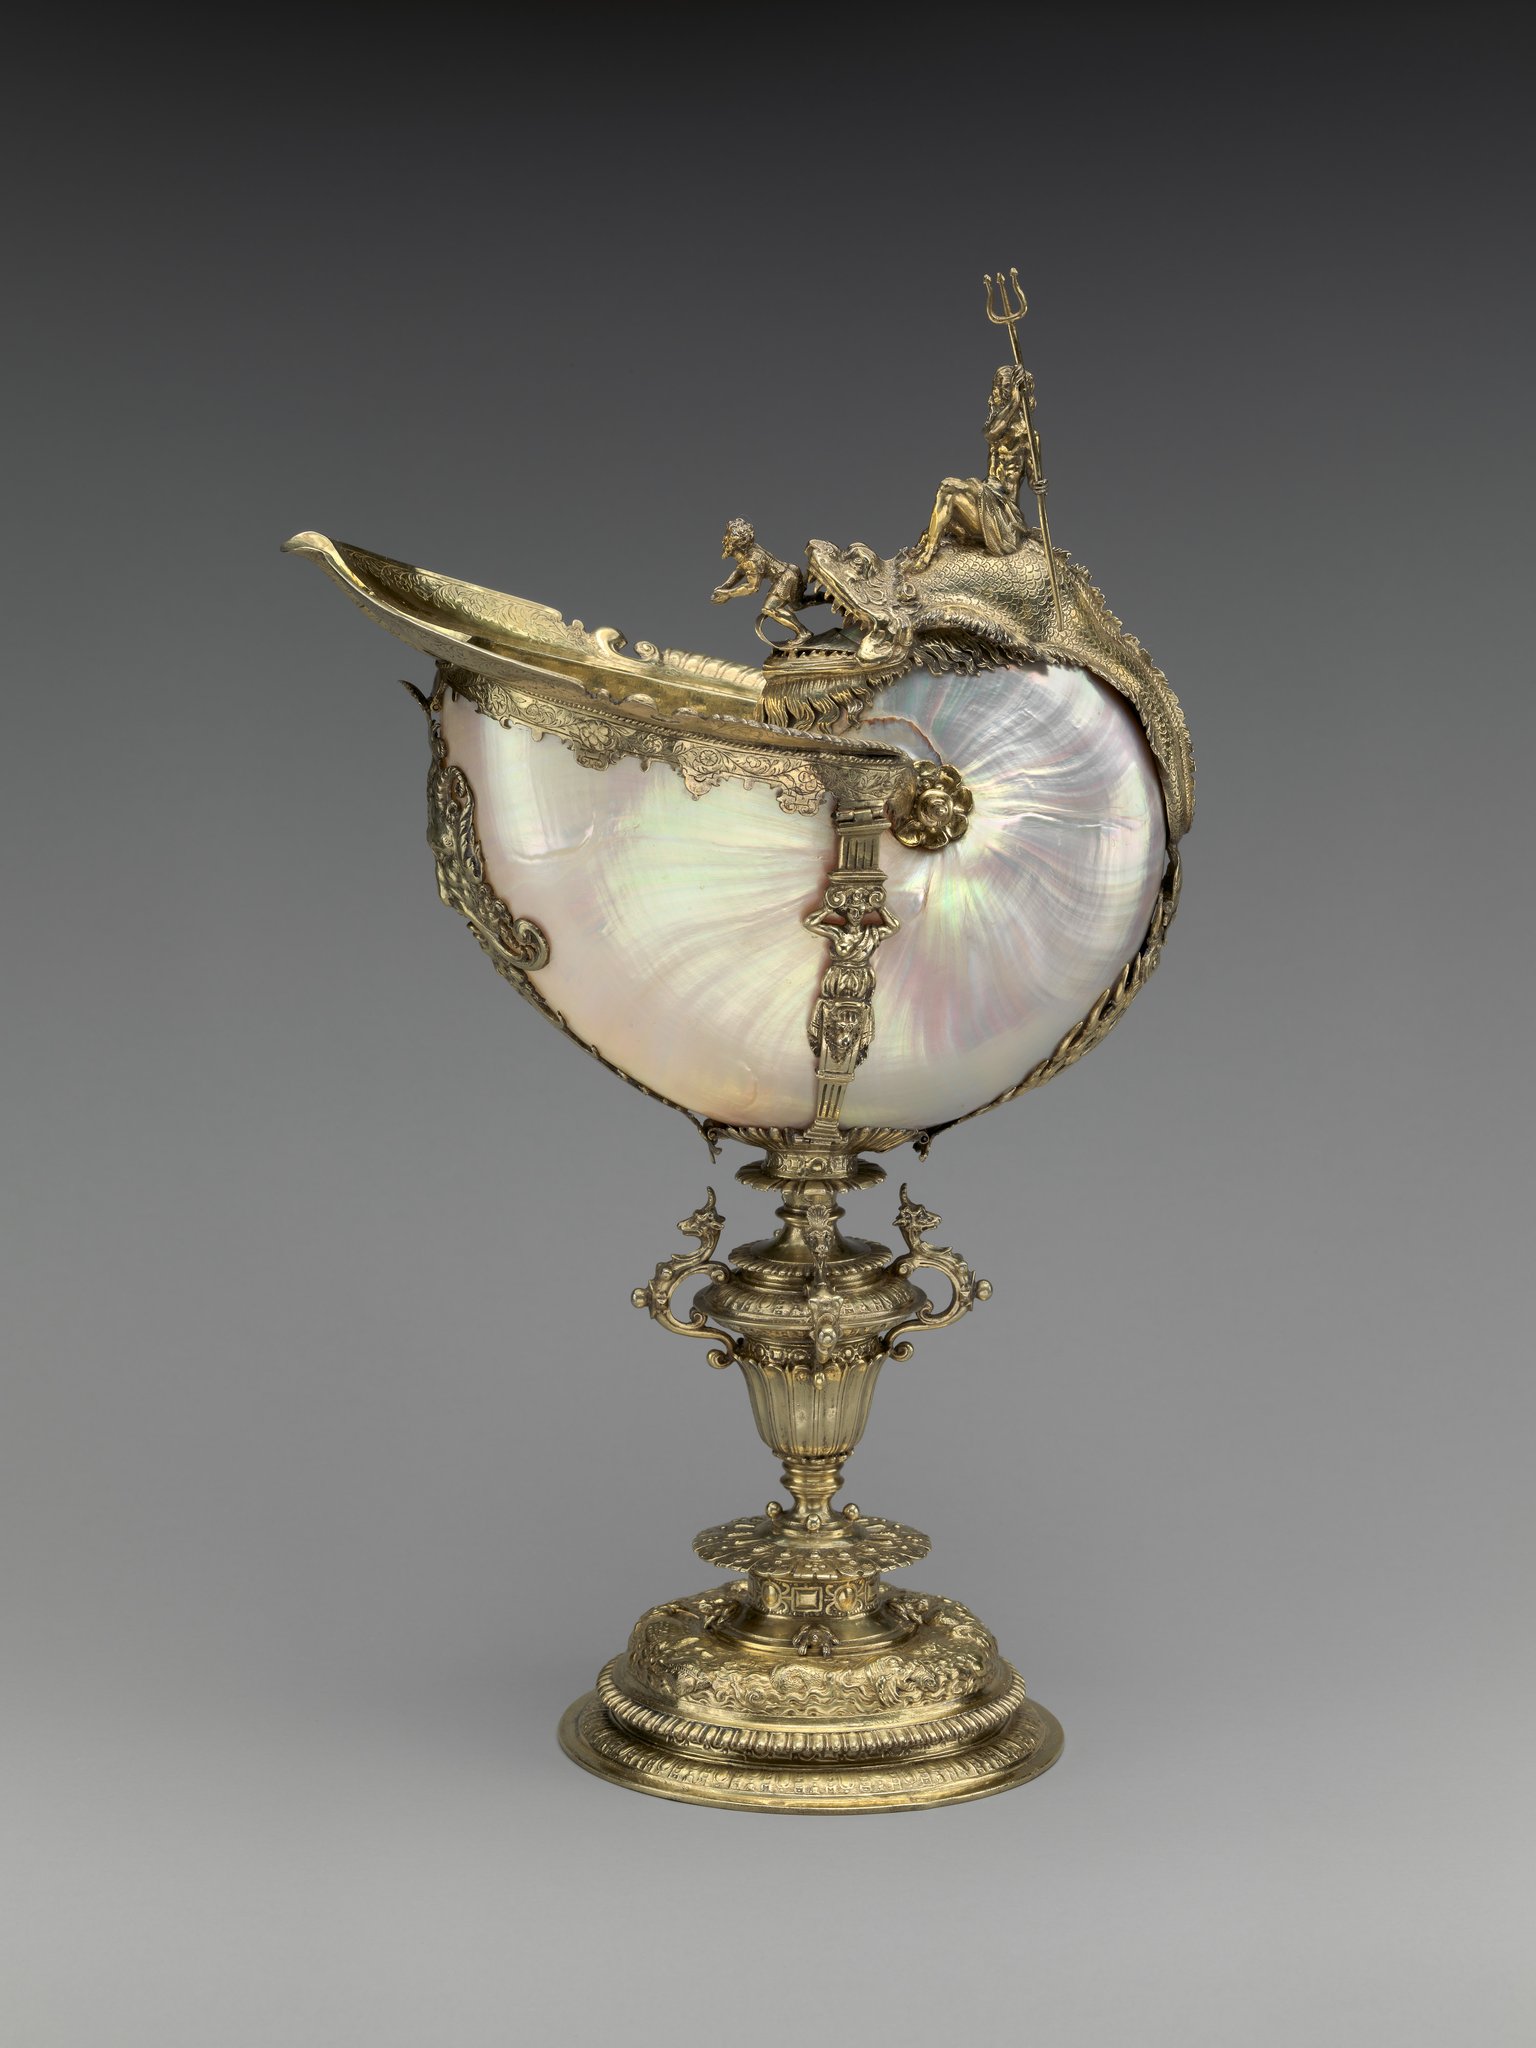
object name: nautilus cup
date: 1602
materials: gilt silver, shell